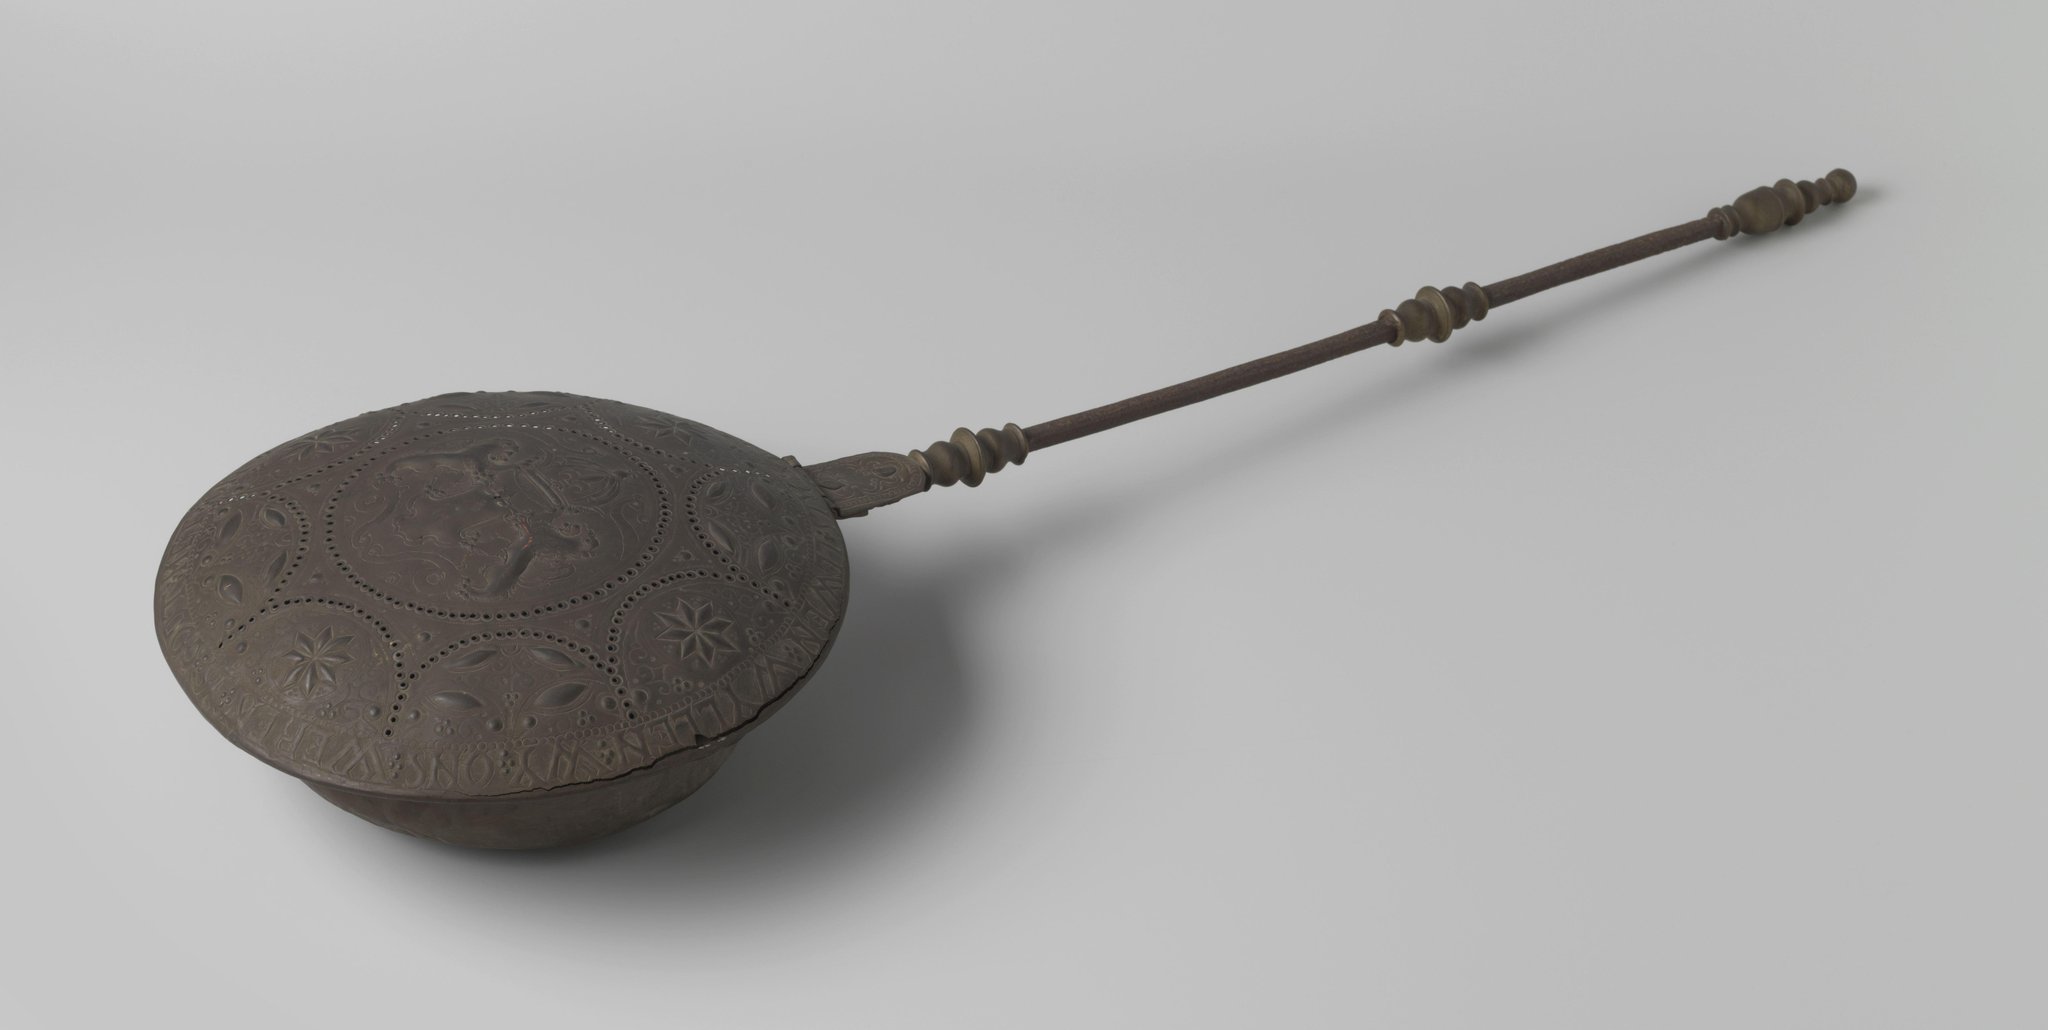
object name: bed warmer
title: Beddenpan met wapenschild tussen twee leeuwen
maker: Anonymous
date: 1600-1650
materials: brass, iron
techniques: casting, engraving, forging, punching, riveted, striking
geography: low countries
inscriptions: inscription: ‘ALS.LEWEN.WYLLEN.WY.ONS.WEREN.GODT.MET.ONS.WY.KAN.ONS.DEREN.’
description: Het voorwerp bestaat uit zeven delen: de ijzeren steel met de ring, waarop de koperen bak is geklonken, het koperen scharnier, het koperen deksel, de drie gegoten koperen sierelementen aan de steel. In het bolle deksel, waarvan het centerpunt zichtbaar is, zijn met behulp van stempelvormen versieringen geponst, geslagen en gegraveerd, en zijn gaatjes in de vorm van een cirkel en van een uit halve bogen opgebouwde achtpuntige ster aangebracht. In het midden een door twee leeuwen opgehouden blank wapenschild met daarboven een kroon. In de velden tussen de halve cirkels zijn uit vormen geponste sterren en spits toelopende ovalen opgenomen in patronen, die uit gegranuleerde lijnen zijn opgebouwd. Langs de rand op gearceerde achtergrond in kapitalen het opschrift ALS LEWEN WYLLEN WY ONS WEREN GODT MET ONS WY KAN ONS DEREN. De rand van het deksel is met ijzerdraad verstevigd. Hat scharnier, waarvan de delen door een ijzeren pin bijeen worden gehouden, heeft een geslagen versiering. De drie gegoten sierelementen aan de voet, het midden en het eind van de steel, hebben de vorm van twee tegen elkaar geplaatste balusters of van een vaas, een baluster en een knop. De hangring ontbreekt.